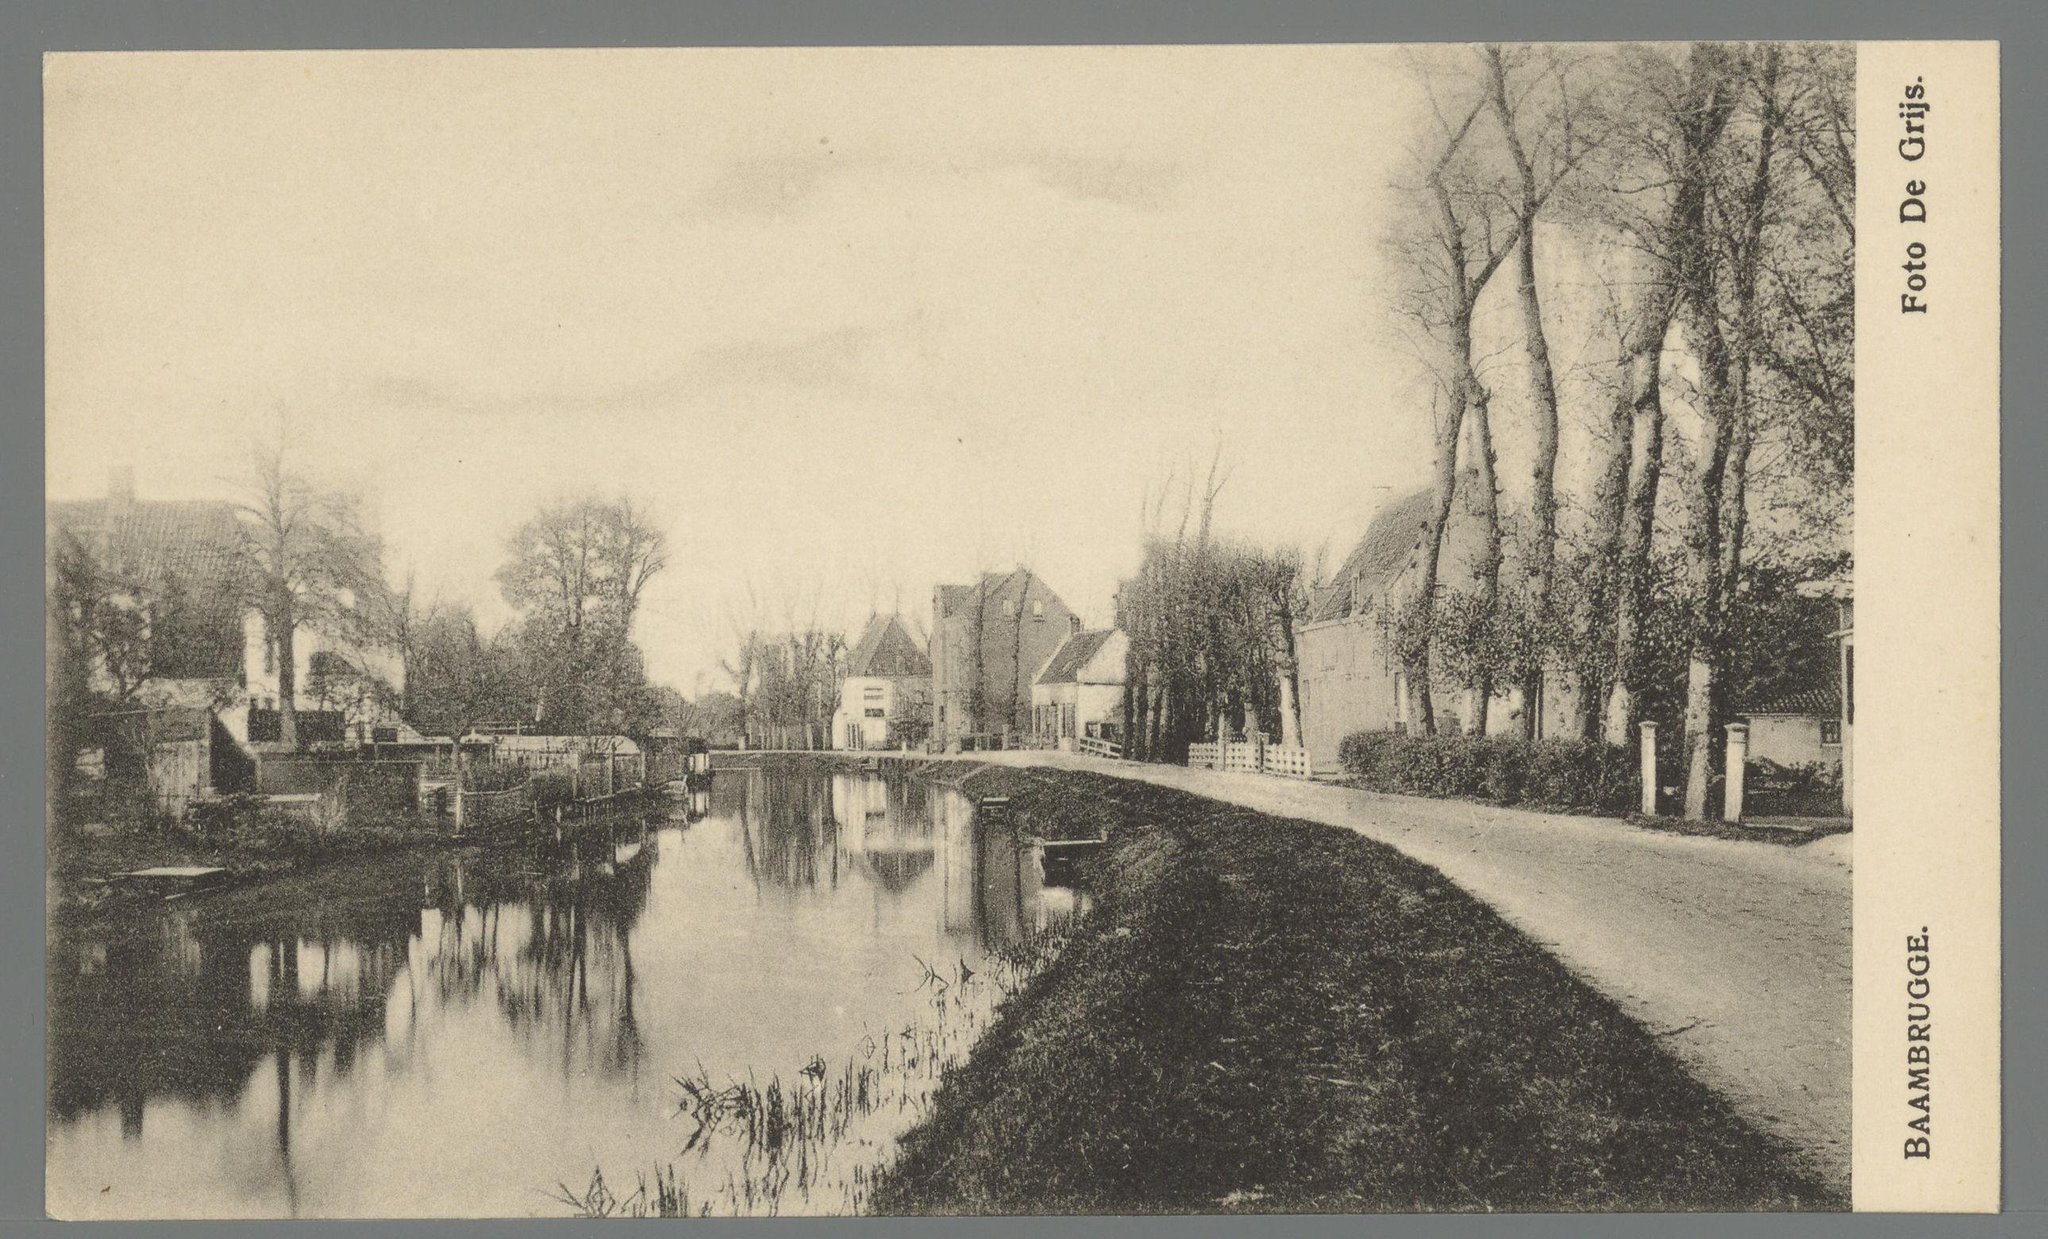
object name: ansichtkaart, prentbriefkaart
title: Baambrugge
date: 1897-1910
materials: cardboard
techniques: photograph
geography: baambrugge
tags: canals, waters (in village), street